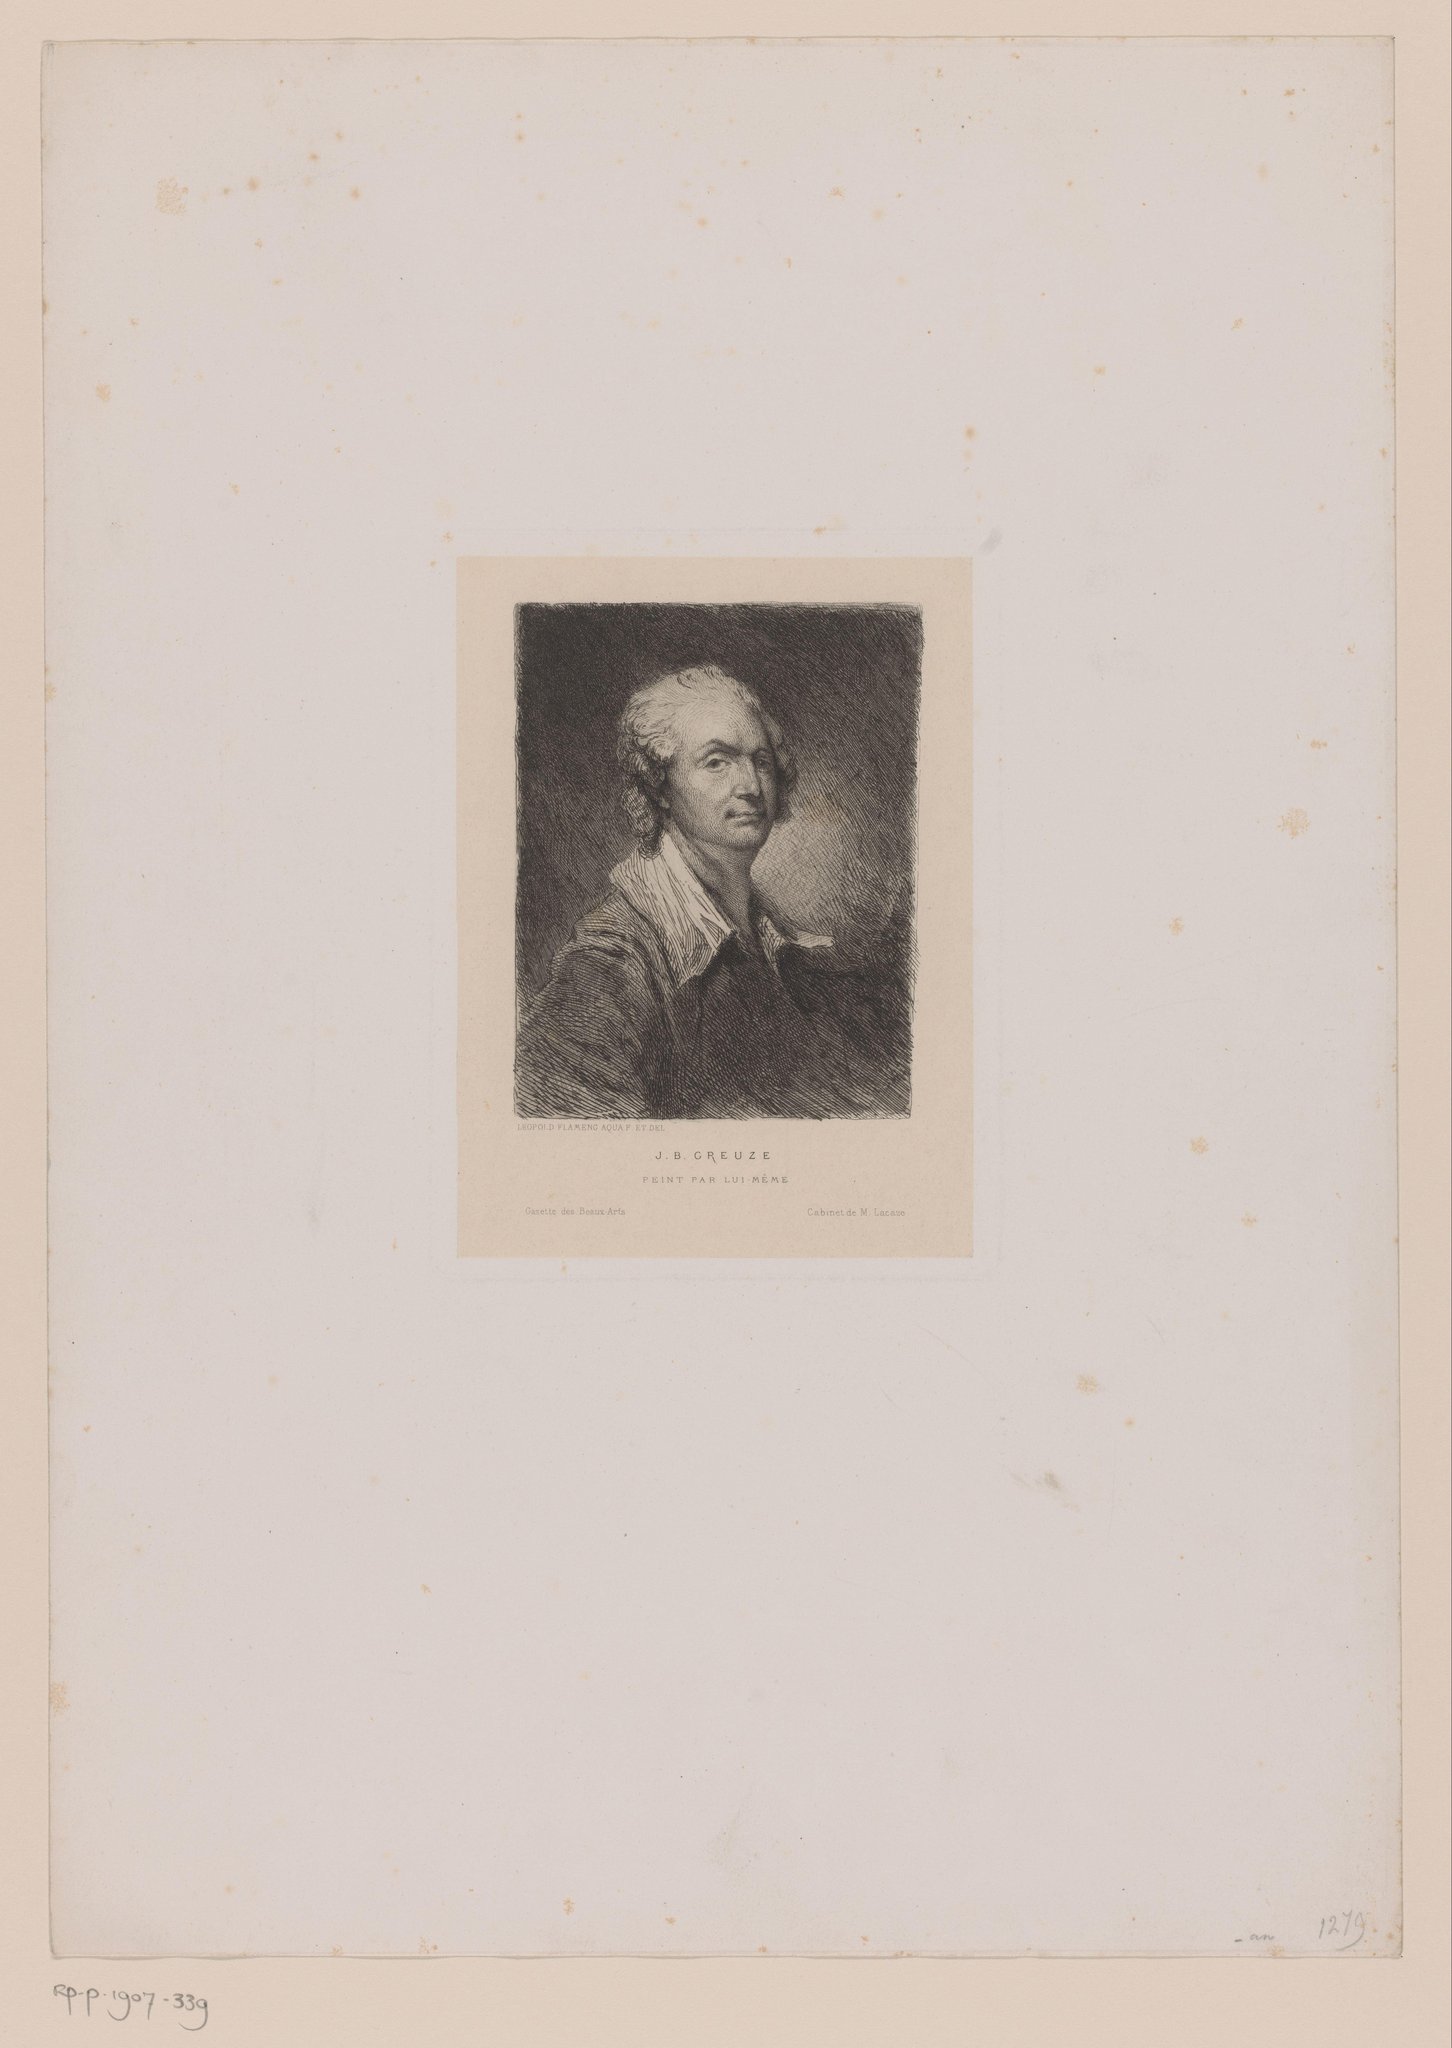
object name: print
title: J.B. Greuze par lui-mème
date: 1862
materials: paper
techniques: etching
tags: paris, painter, jean-baptiste greuze, portrait, self-portrait of painter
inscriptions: collector's mark: Lugt 2228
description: Prent uit: Gazette des beaux-arts (1862), dl. 2, p. 402.